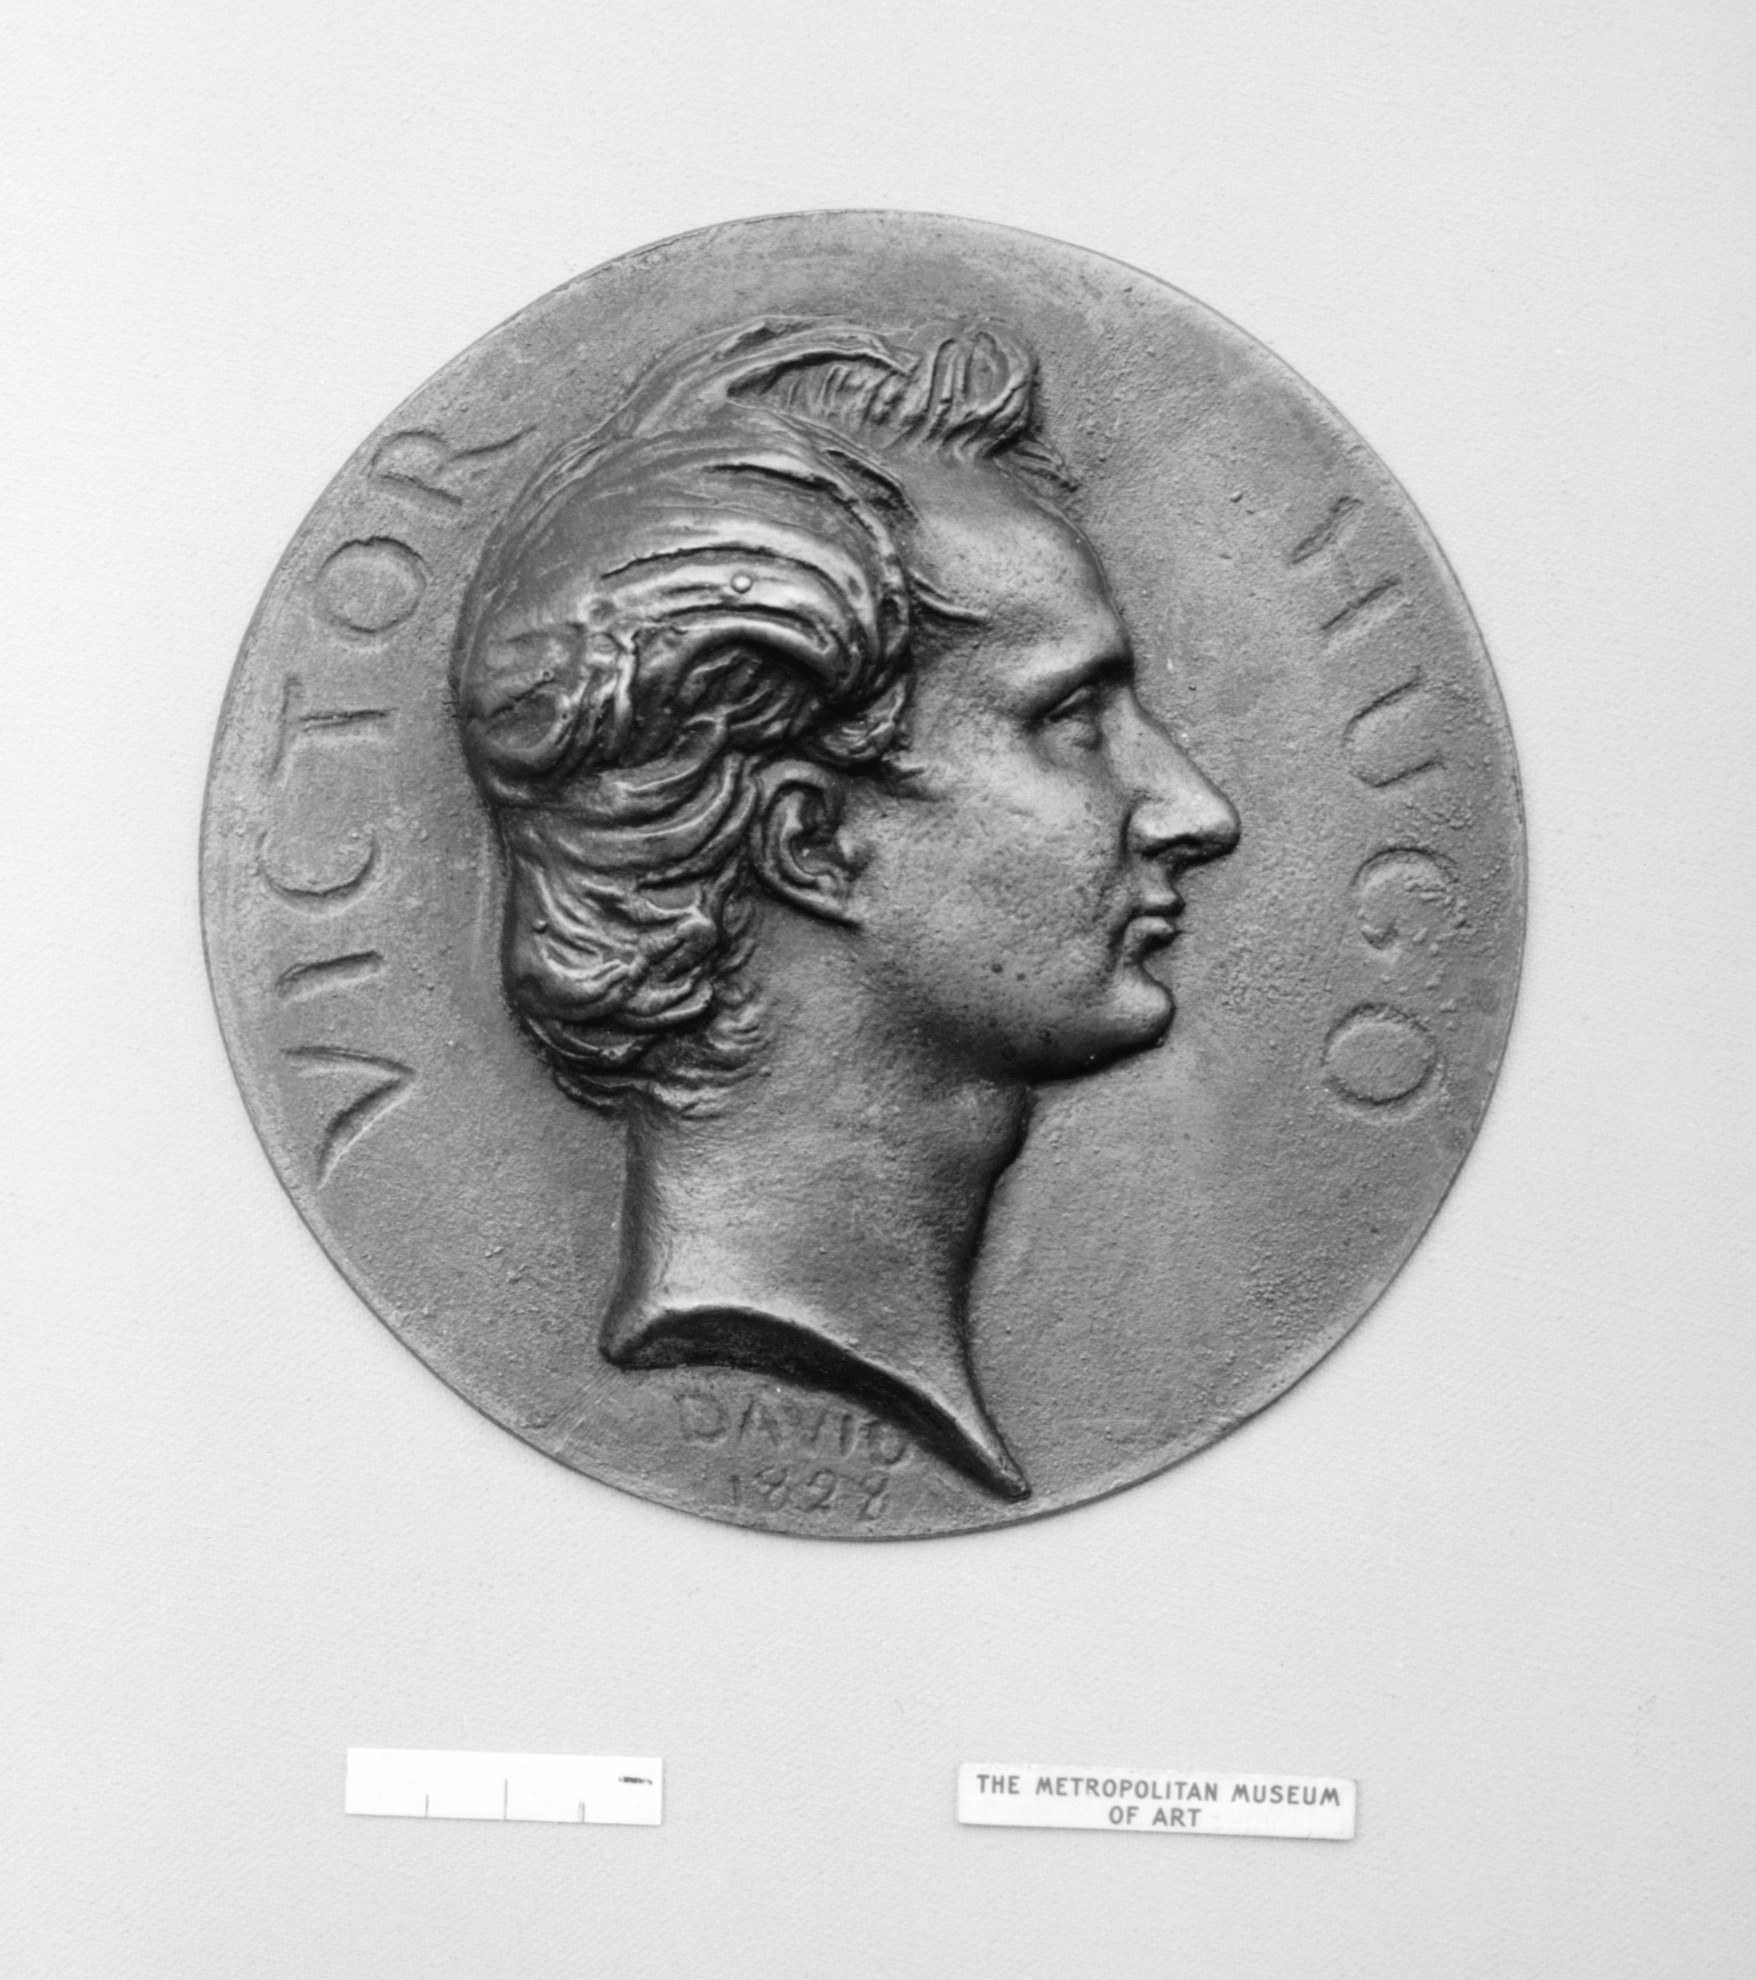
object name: medallion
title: Youthful portrait of Victor Hugo (1802–1885), French poet and novelist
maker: pierre jean david d'angers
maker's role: artist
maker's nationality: french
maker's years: 1788-1856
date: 1828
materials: bronze, patina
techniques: casting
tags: men,profiles,poets